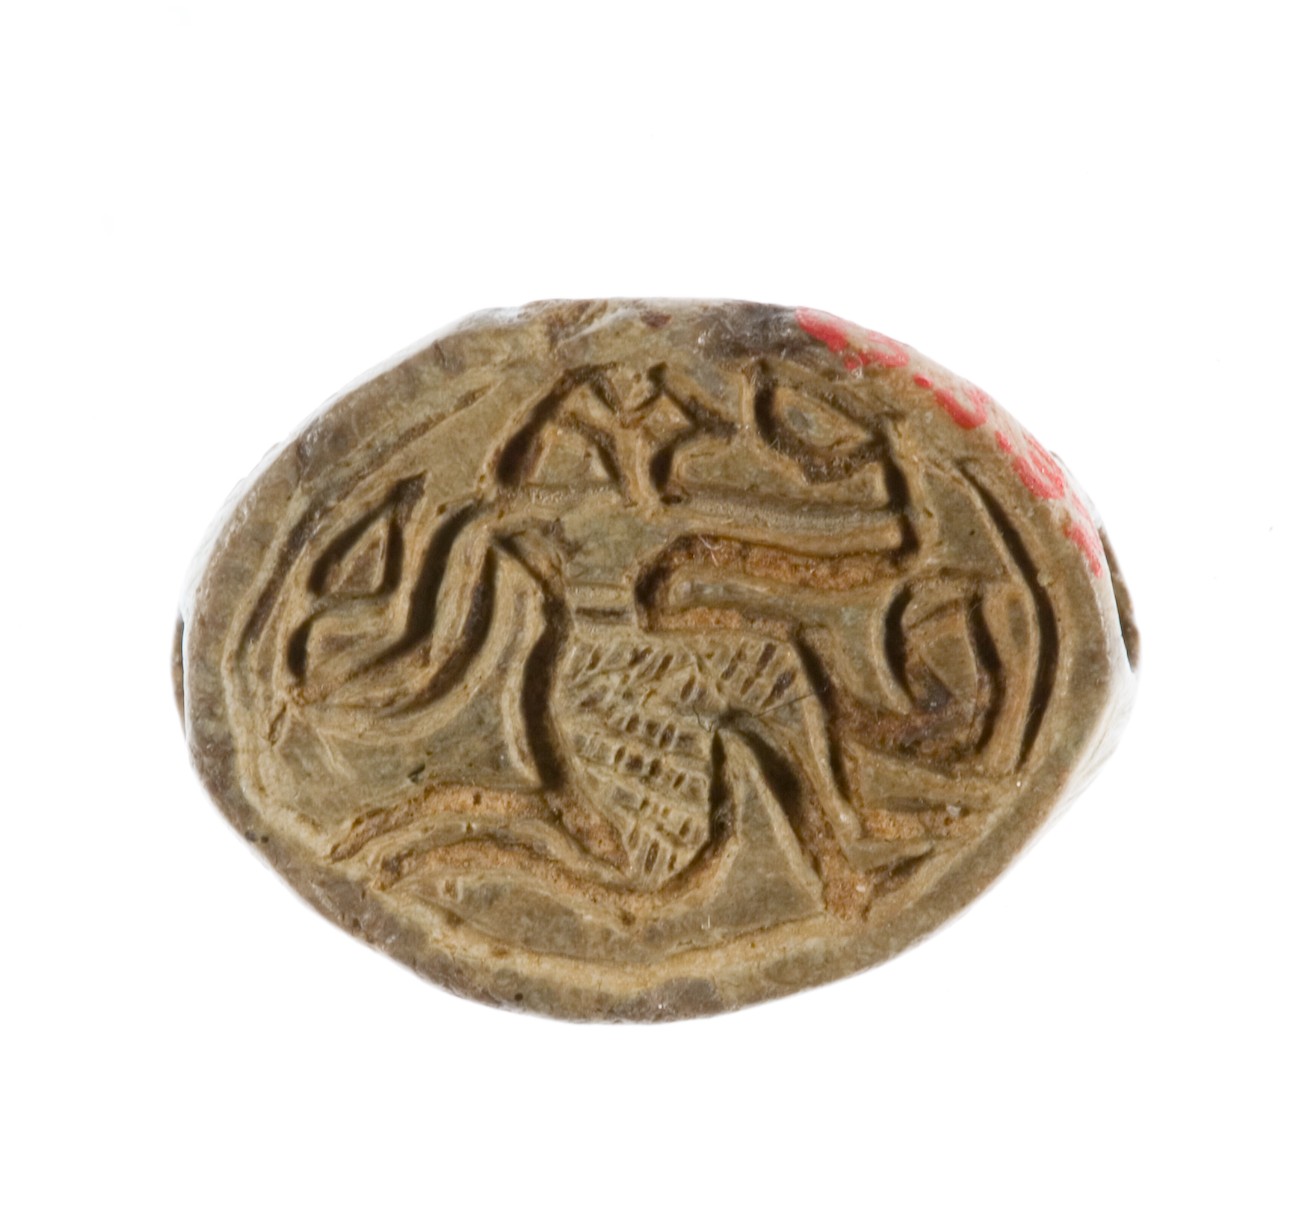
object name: cowroid seal amulet, falcon headed deity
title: Canaanite Cowroid Seal Amulet with Falcon Headed Deity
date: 1600-1500 BCE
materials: stone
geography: canaan